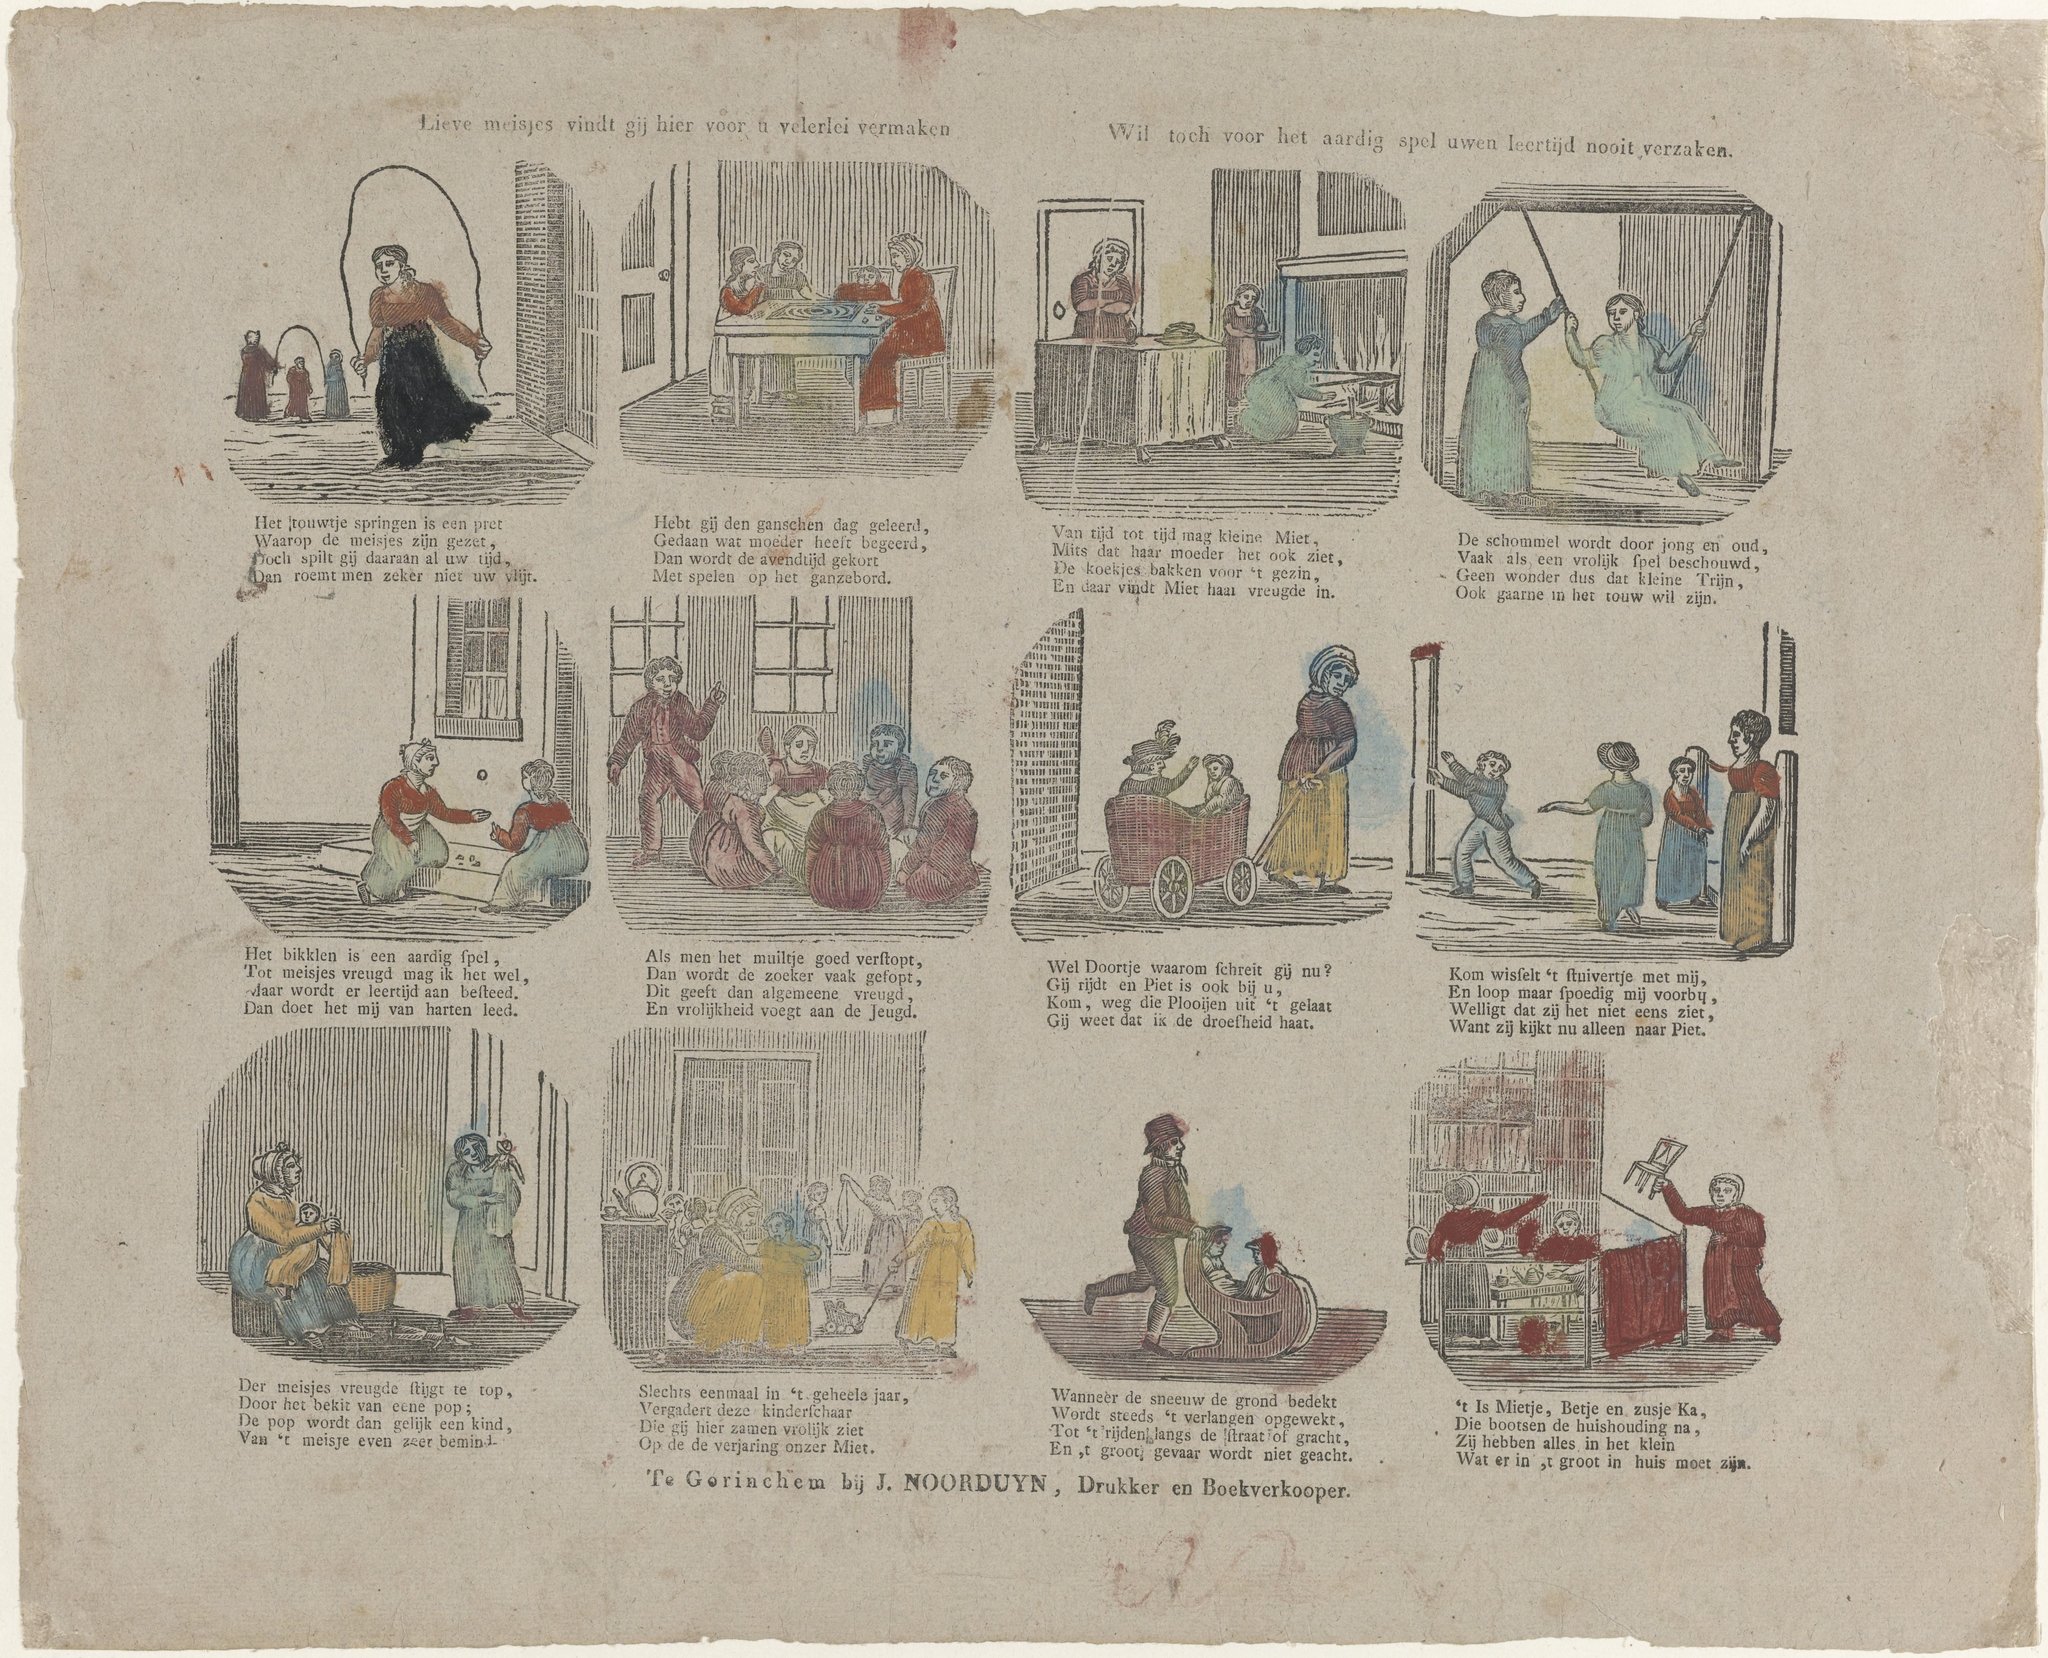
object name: print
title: Lieve meisjes vindt gij hier voor n velerlei vermaken / Wil toch voor het aardig spel uwen leertijd nooit verzaken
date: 1819-1840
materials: paper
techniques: colour, letterpress printing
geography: gorinchem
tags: goose-game, children's games and plays, child, (playing with) dolls, swinging (children's game), jumping-rope games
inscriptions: collector's mark: Lugt 2760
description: Blad met 12 voorstellingen van kinderspelen voor meisjes, waaronder touwtjespringen, ganzenborden, schommelen en met de pop spelen. Onder elke afbeelding een vierregelig vers.